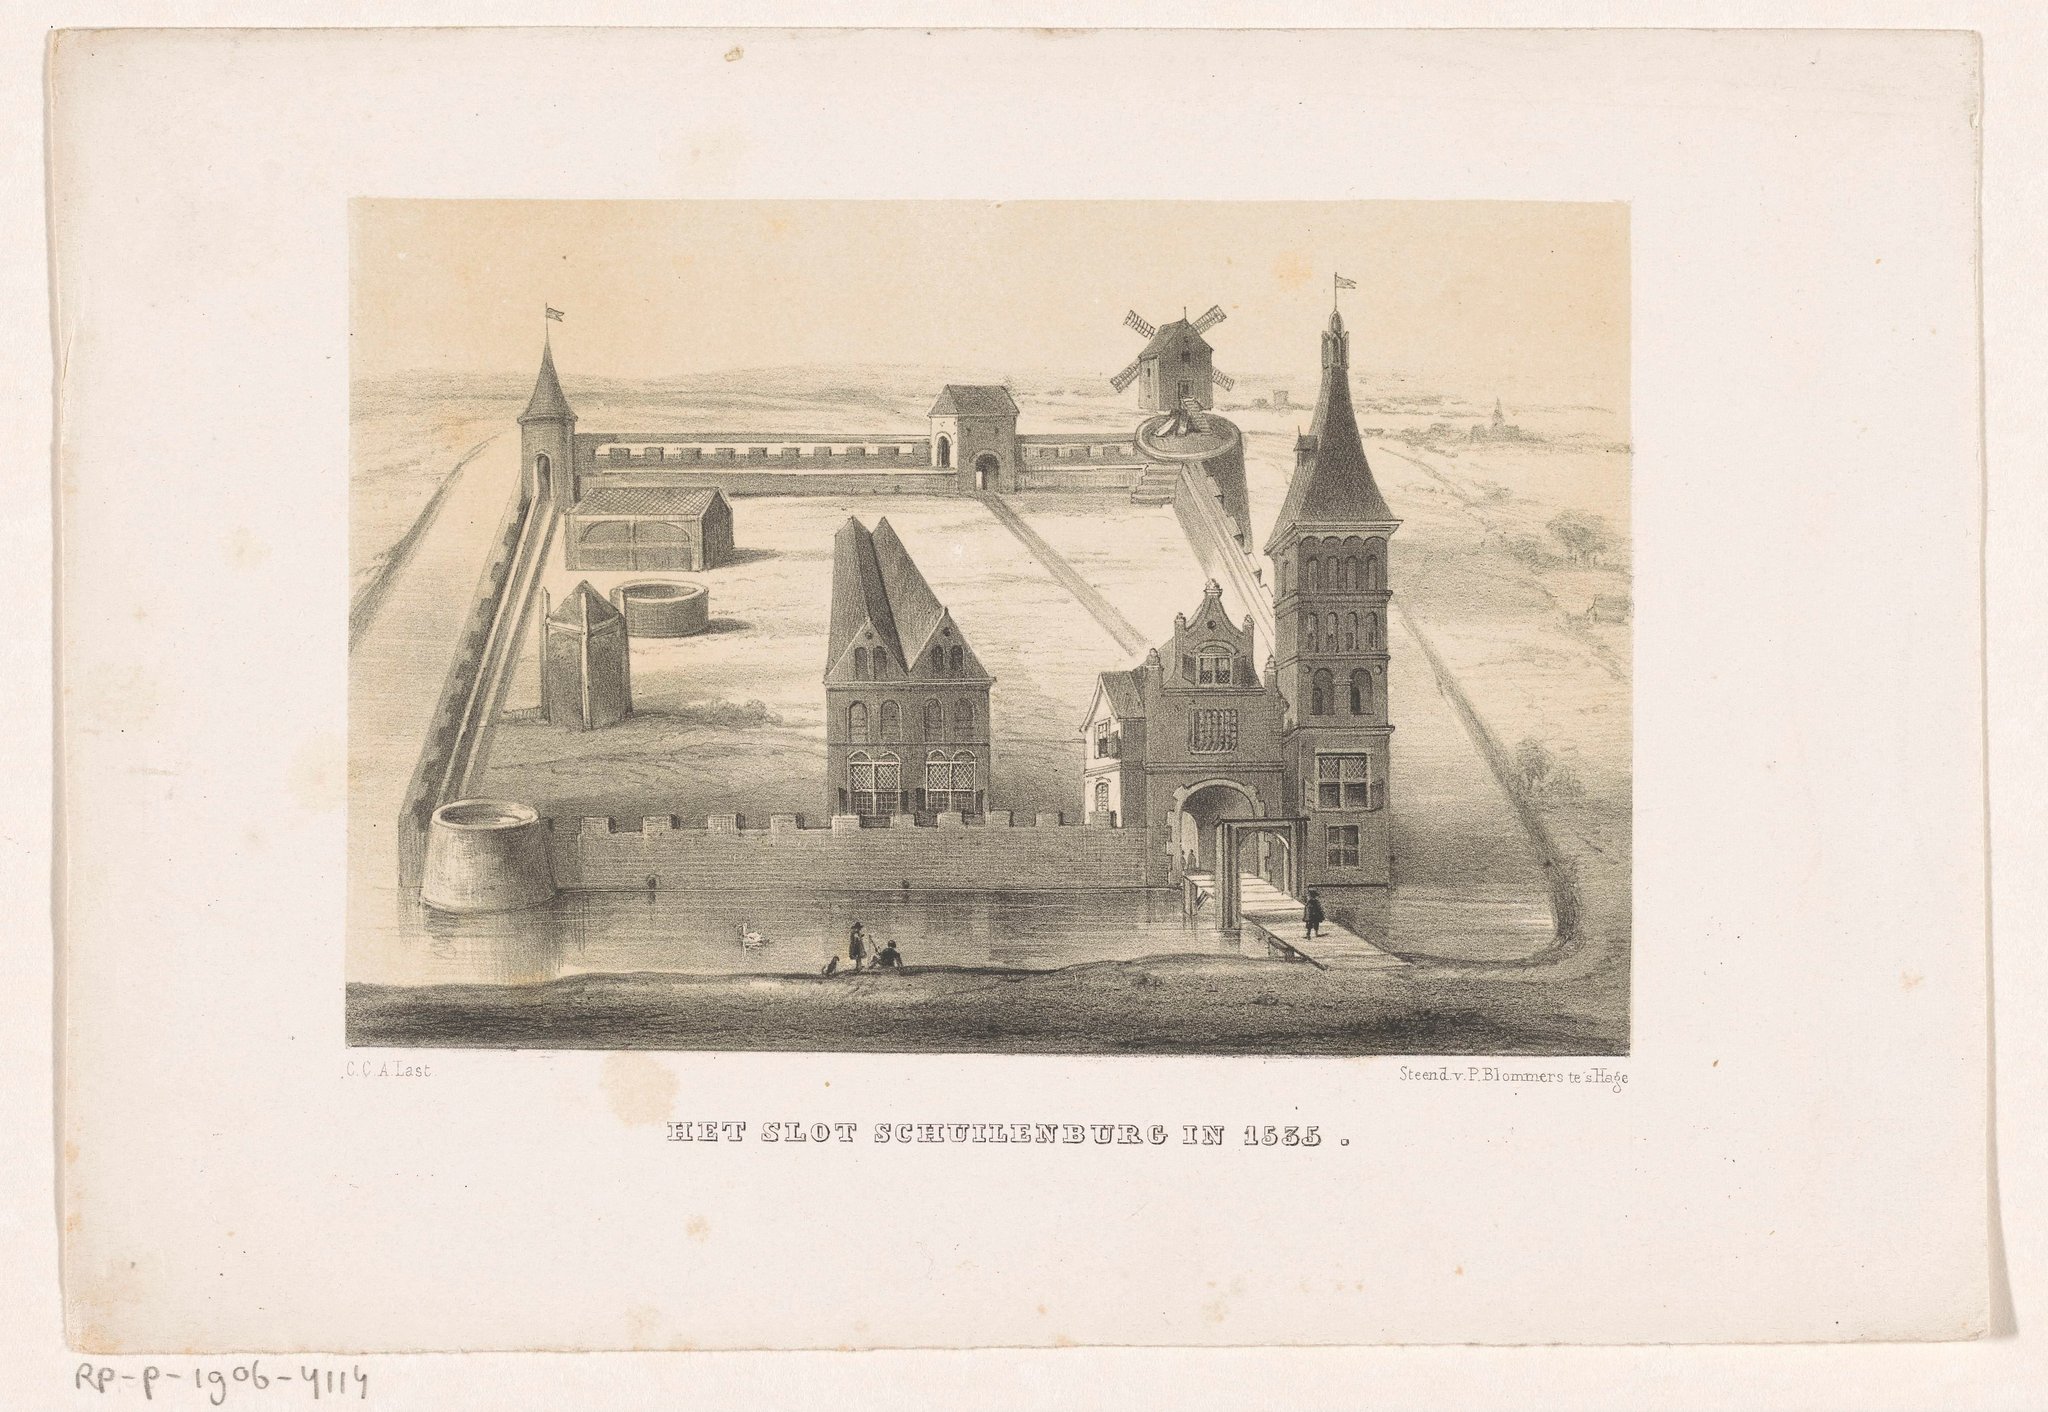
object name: print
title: Slot Schuilenburg in Gelderland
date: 1818-1876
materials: paper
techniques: tone lithography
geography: the hague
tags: castle, windmill, gelderland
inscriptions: collector's mark: Lugt 2228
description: Het zestiende-eeuwse kasteel is vanuit de lucht gezien. Op een hoek van de vestingmuur staat een windmolen.